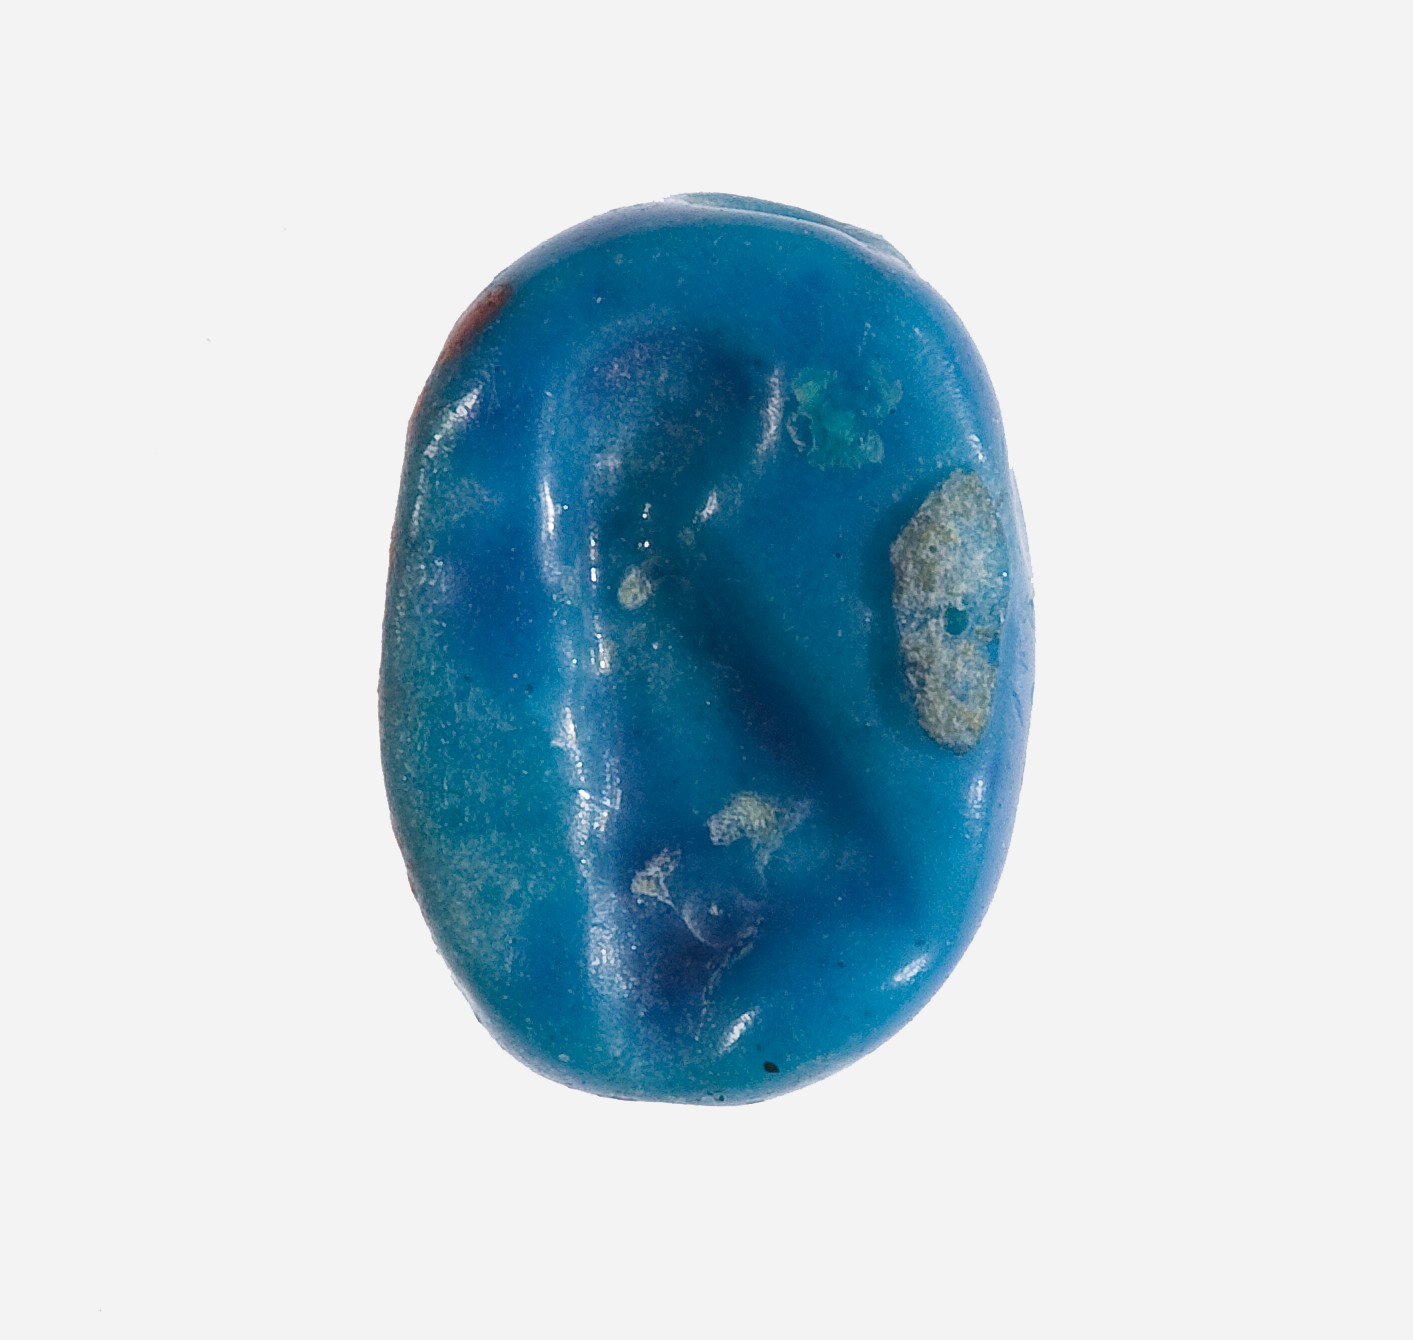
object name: scarab, maat feather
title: Scarab Inscribed with a Maat Feather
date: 1390-1352 BCE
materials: faience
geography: egypt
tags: scarabs